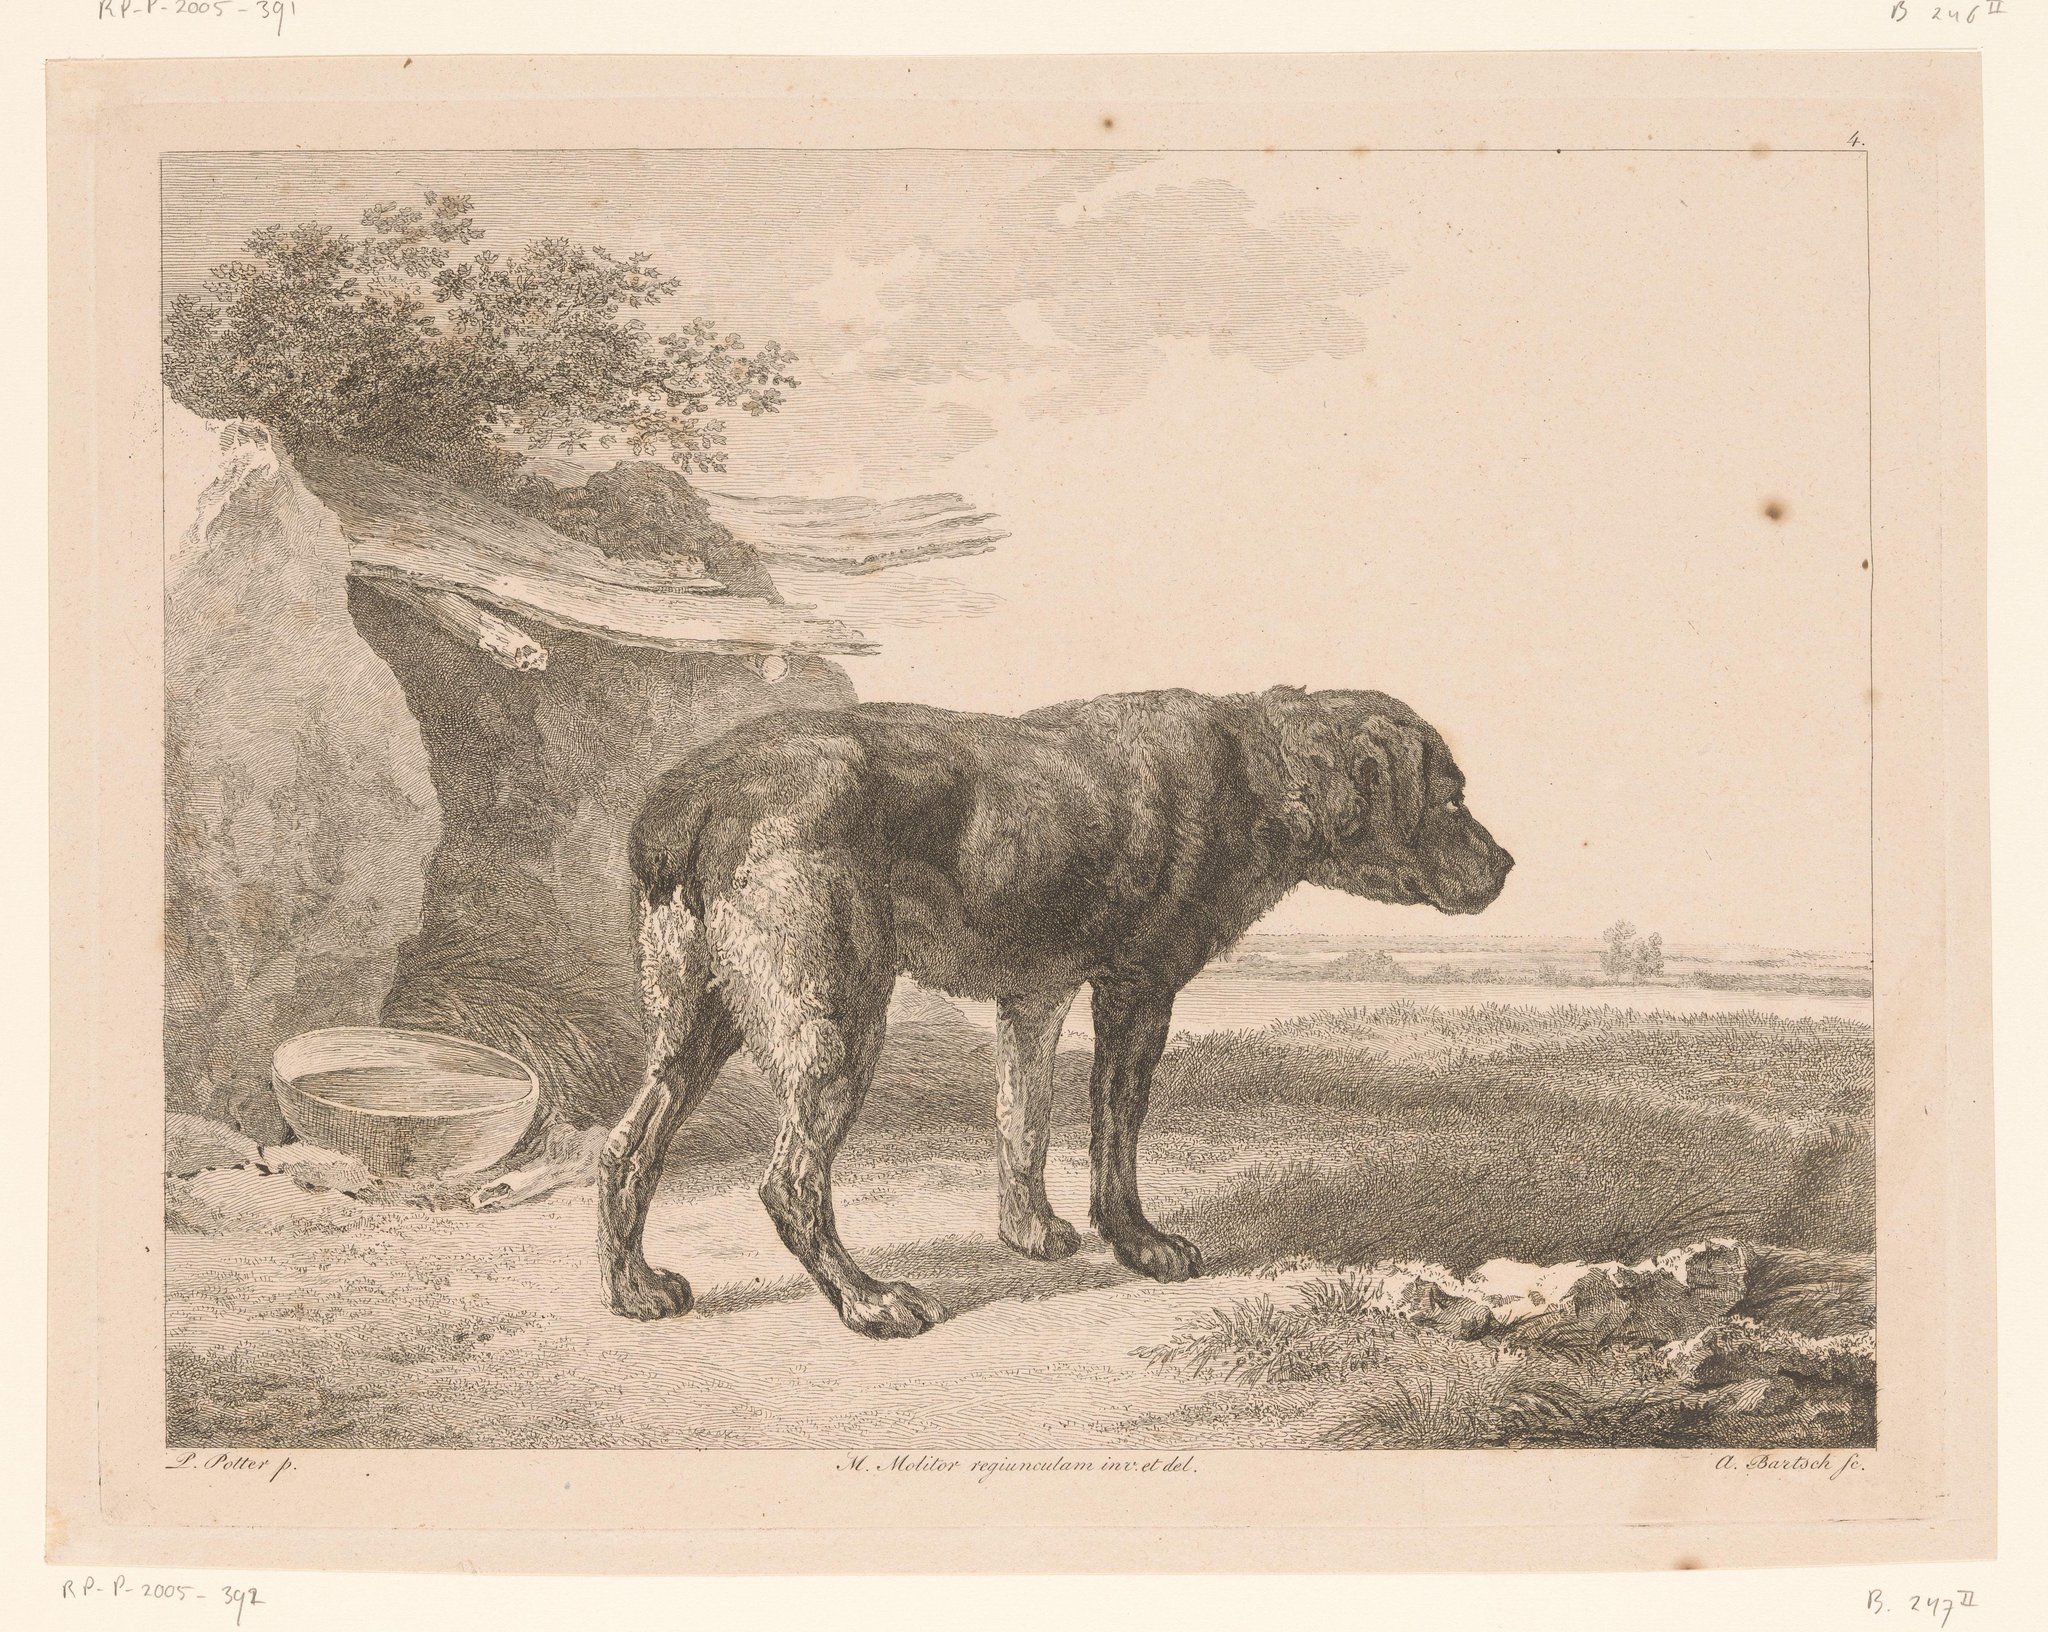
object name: print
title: Dieren naar schilderijen van Hollandse meesters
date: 1809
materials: paper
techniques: etching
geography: vienna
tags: landscapes, dog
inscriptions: collector's mark: Lugt 2228, collector's mark: Lugt 2760